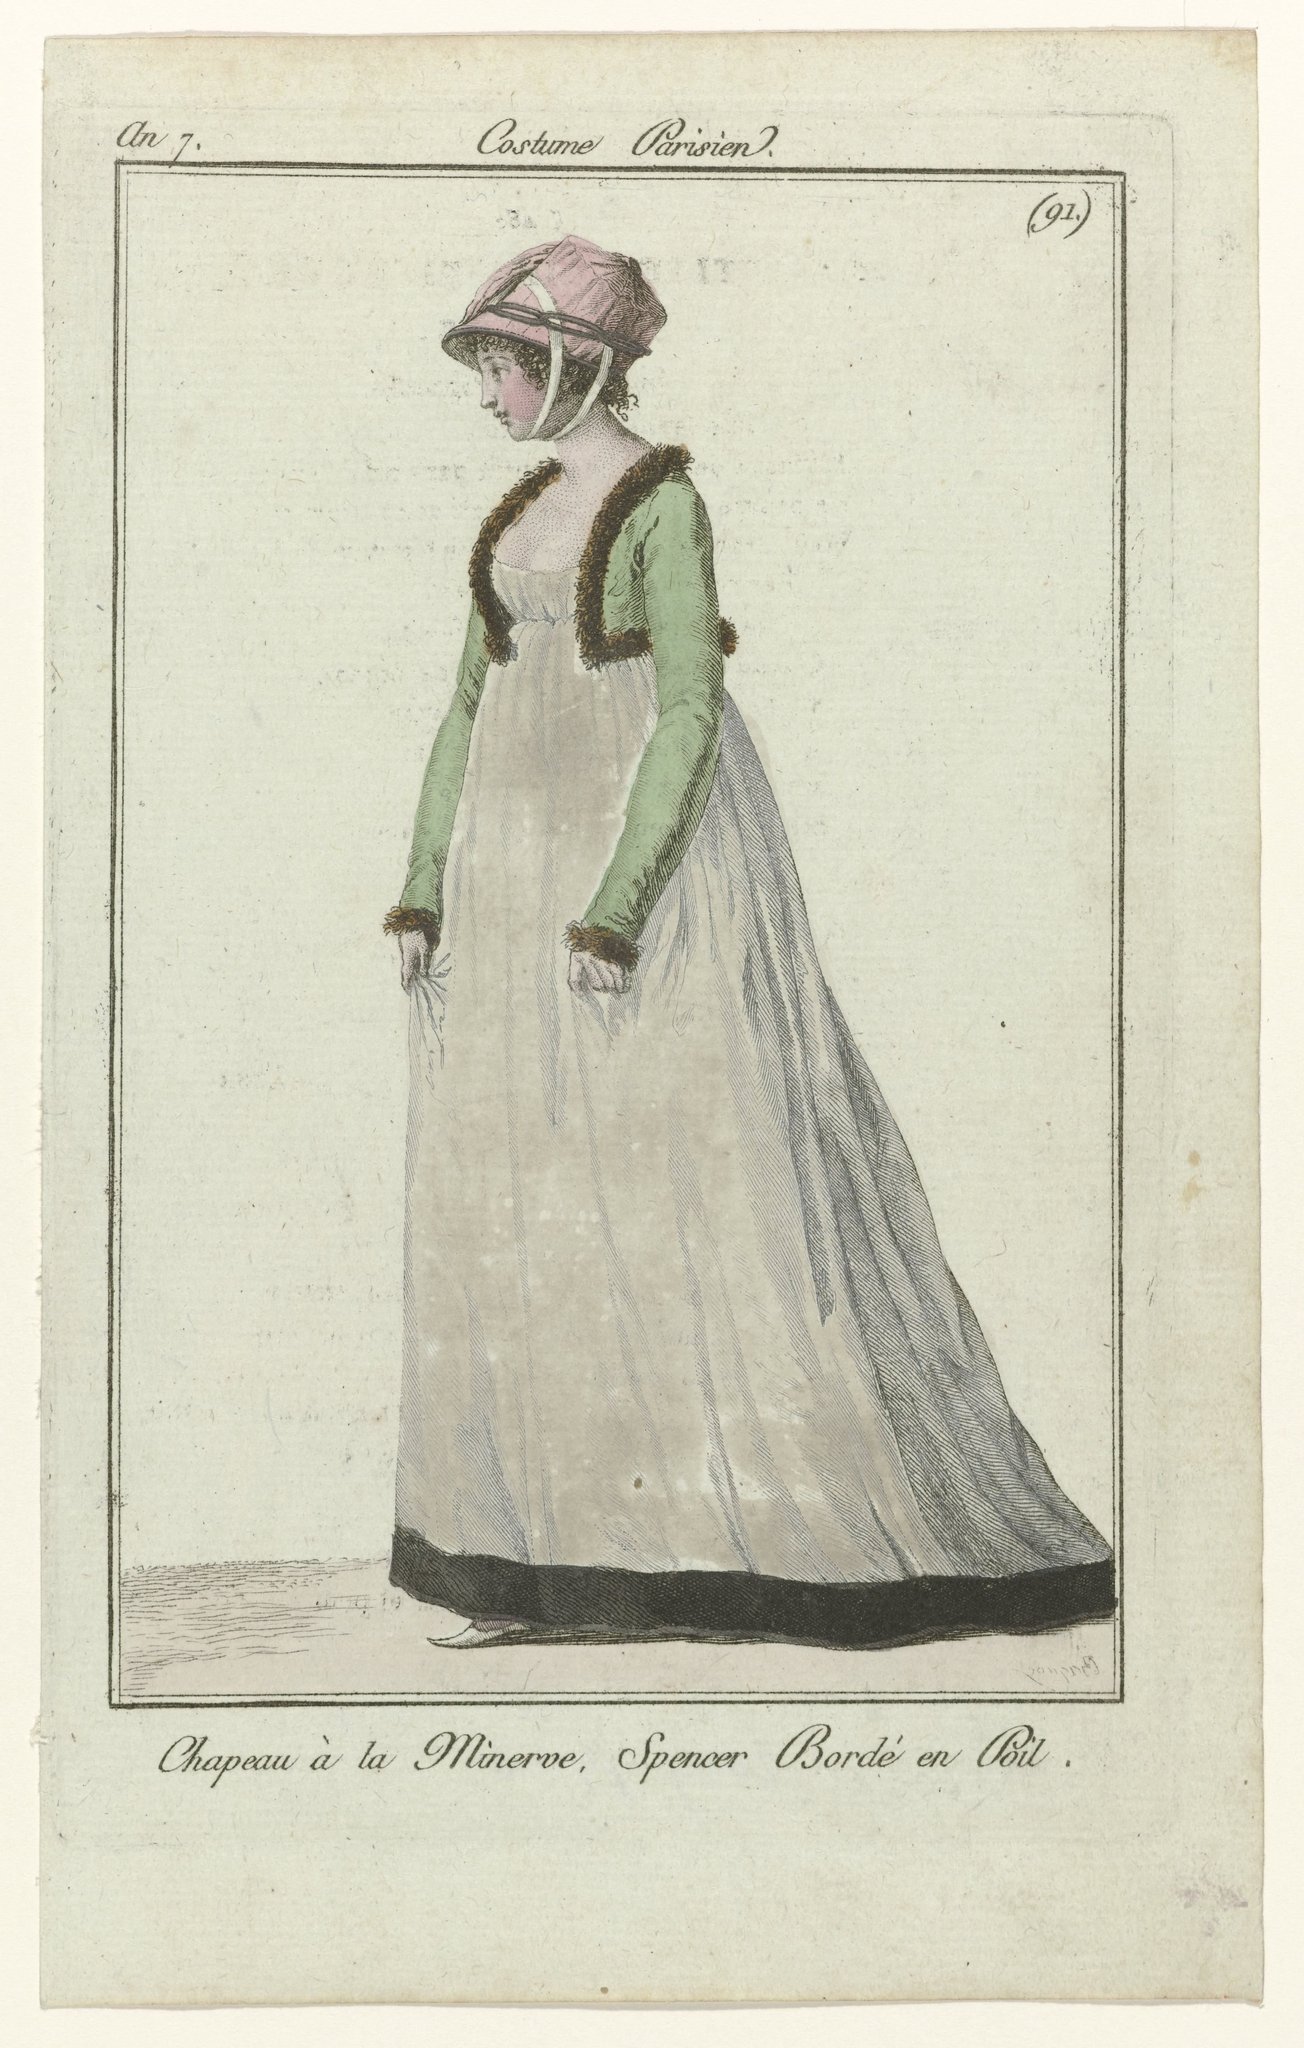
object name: fashion print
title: Journal des Dames et des Modes, Costume Parisien, 23 février 1799, An 7 (91) : Chapeau à la Minerv (...)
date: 1799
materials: paper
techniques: engraving, hand coloring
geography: paris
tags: clothing for the upper part of the body (spencer) (+ women's clothes), fashion plates, head-gear: hat (+ women's clothes), shoes, sandals (+ women's clothes), dress, gown (+ women's clothes)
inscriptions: caption: ‘Chapeau à la Minerve. Spencer Bordé en Poil.’, title: ‘Costume Parisien.’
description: Hoed met de naam 'Chapeau à la Minerve'. Spencer afgezet met bont op een japon met sleep, afgezet met contrasterend band. platte schoen met puntige neus. De prent maakt deel uit van het modetijdschrift Journal des Dames et des Modes, uitgegeven door Sellèque, Parijs, 1797-1839.